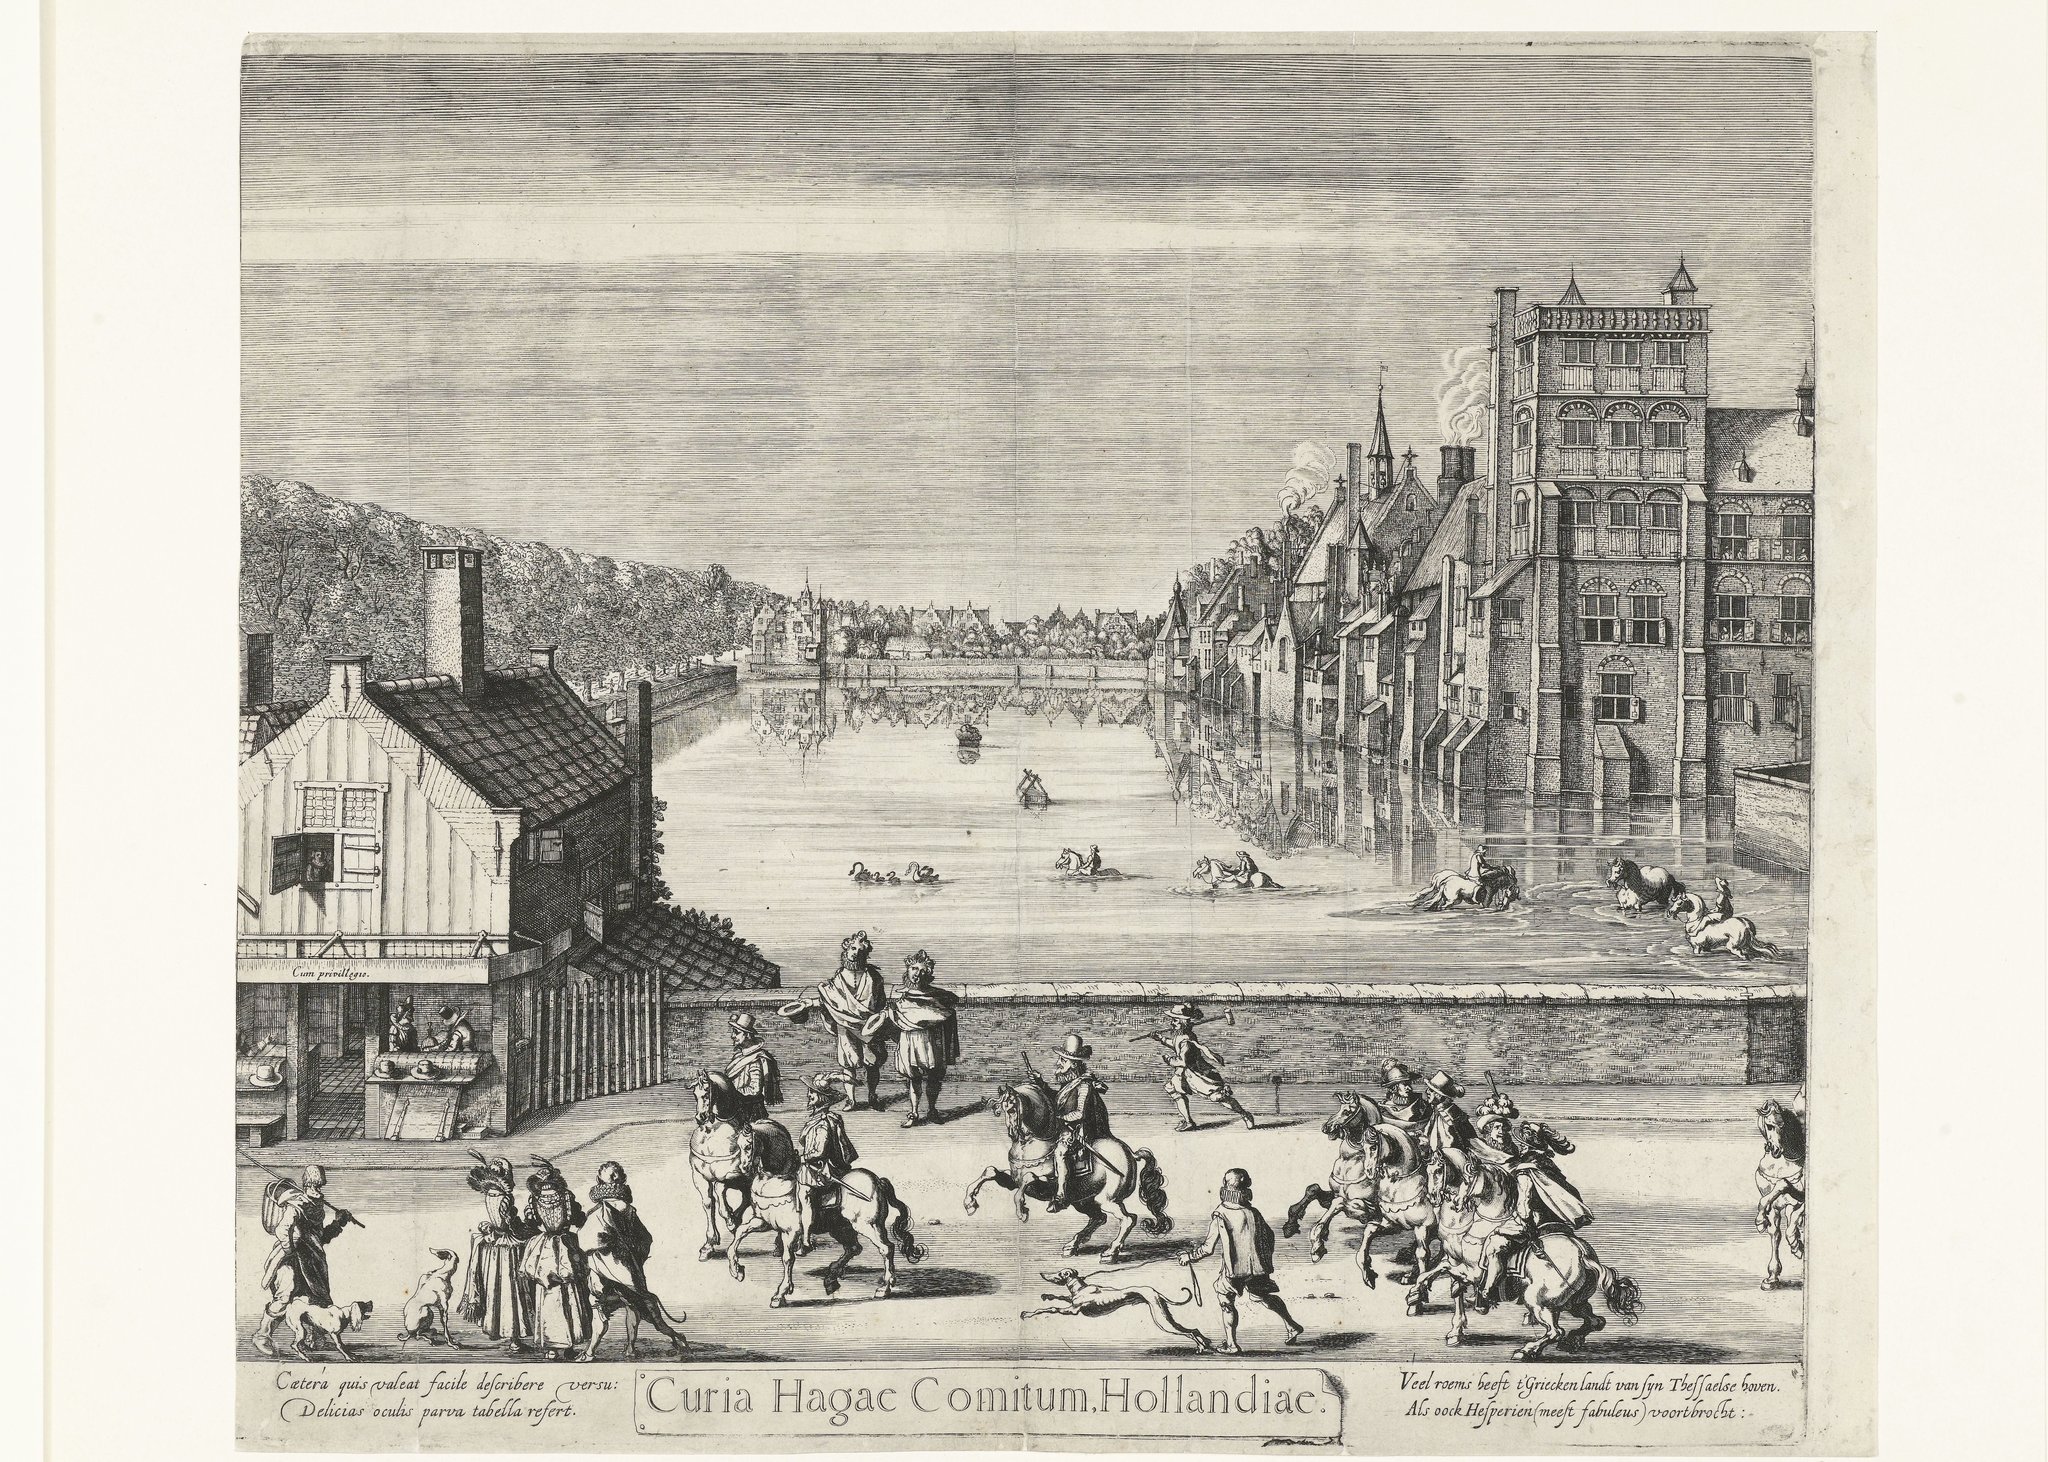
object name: print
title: Curia Hagae Comitum, Hollandiae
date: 1621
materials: paper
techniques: engraving, etching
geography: northern netherlands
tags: binnenhof, hofvijver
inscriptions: date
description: Gezicht op het Binnenhof en de Hofvijver te Den Haag, in drie platen (middenblad), 1621. Links een hoedenwinkeltje, centraal de Hofvijver en de gebouwen van het Hof. In het onderschrift 2 regels in het Latijn en 2 regels in het Nederlands.